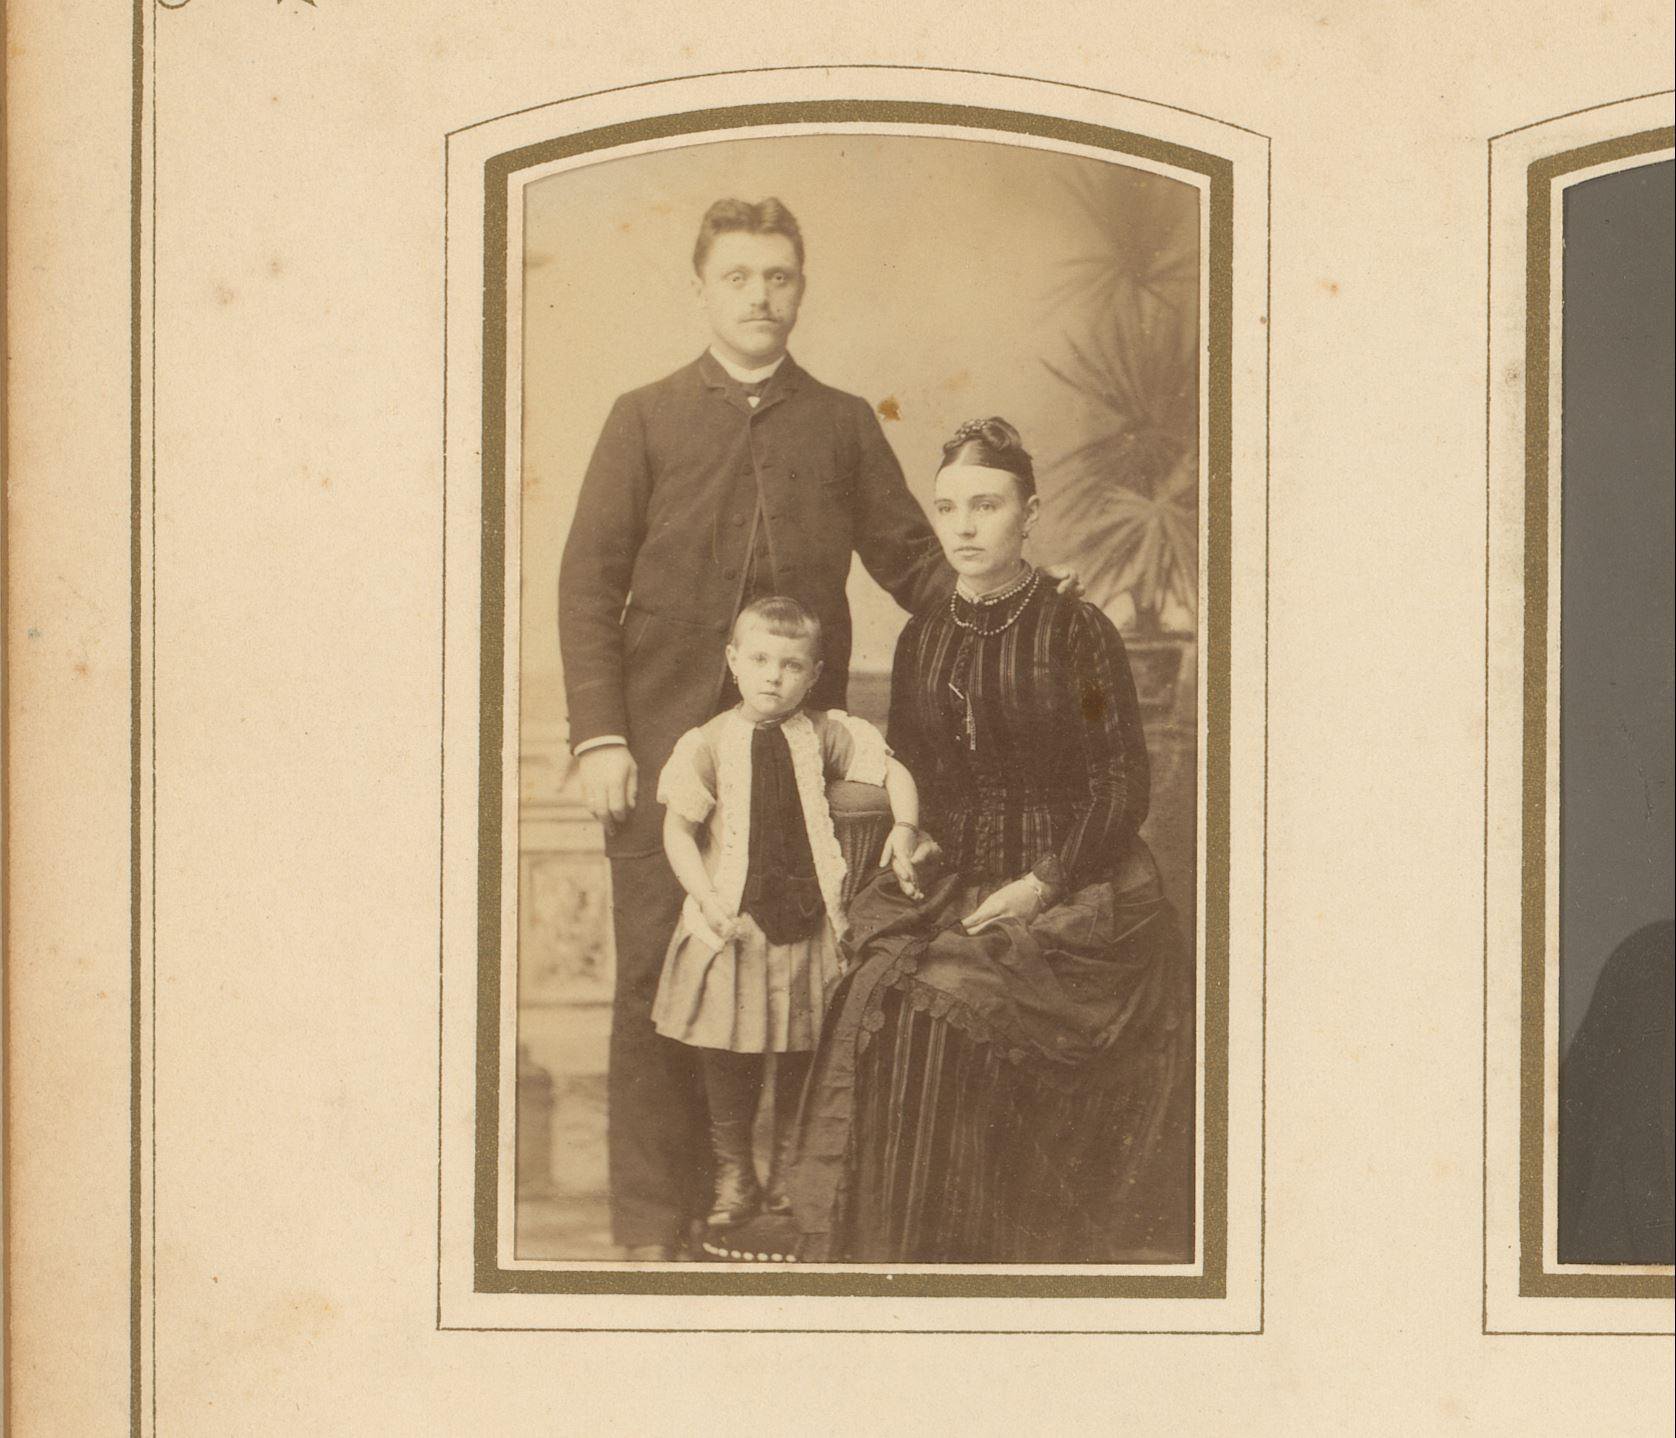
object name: carte de visite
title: Portret van een staande man, een zittende vrouw en een staand meisje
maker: thomas martin staas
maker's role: fotograaf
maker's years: 1844-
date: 1865-1895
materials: cardboard, photographic support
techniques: albumen print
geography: leeuwarden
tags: standing figure, sitting figure - aa - female human figure, girl (child between toddler and youth), anonymous historical persons portrayed in a group, in a group-portrait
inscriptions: inscription: ‘Hofphotograaf/ van Z. M. den Koning der Nederlanden/ Th. M. Staas/ Firma: E. Fuchs/ Leeuwarden/ Willemskade Zuidzijde Let. W 1/ over de Beurs./ Voor nabestellingen en vergootingen/ worden alle negatieven bewaard.’